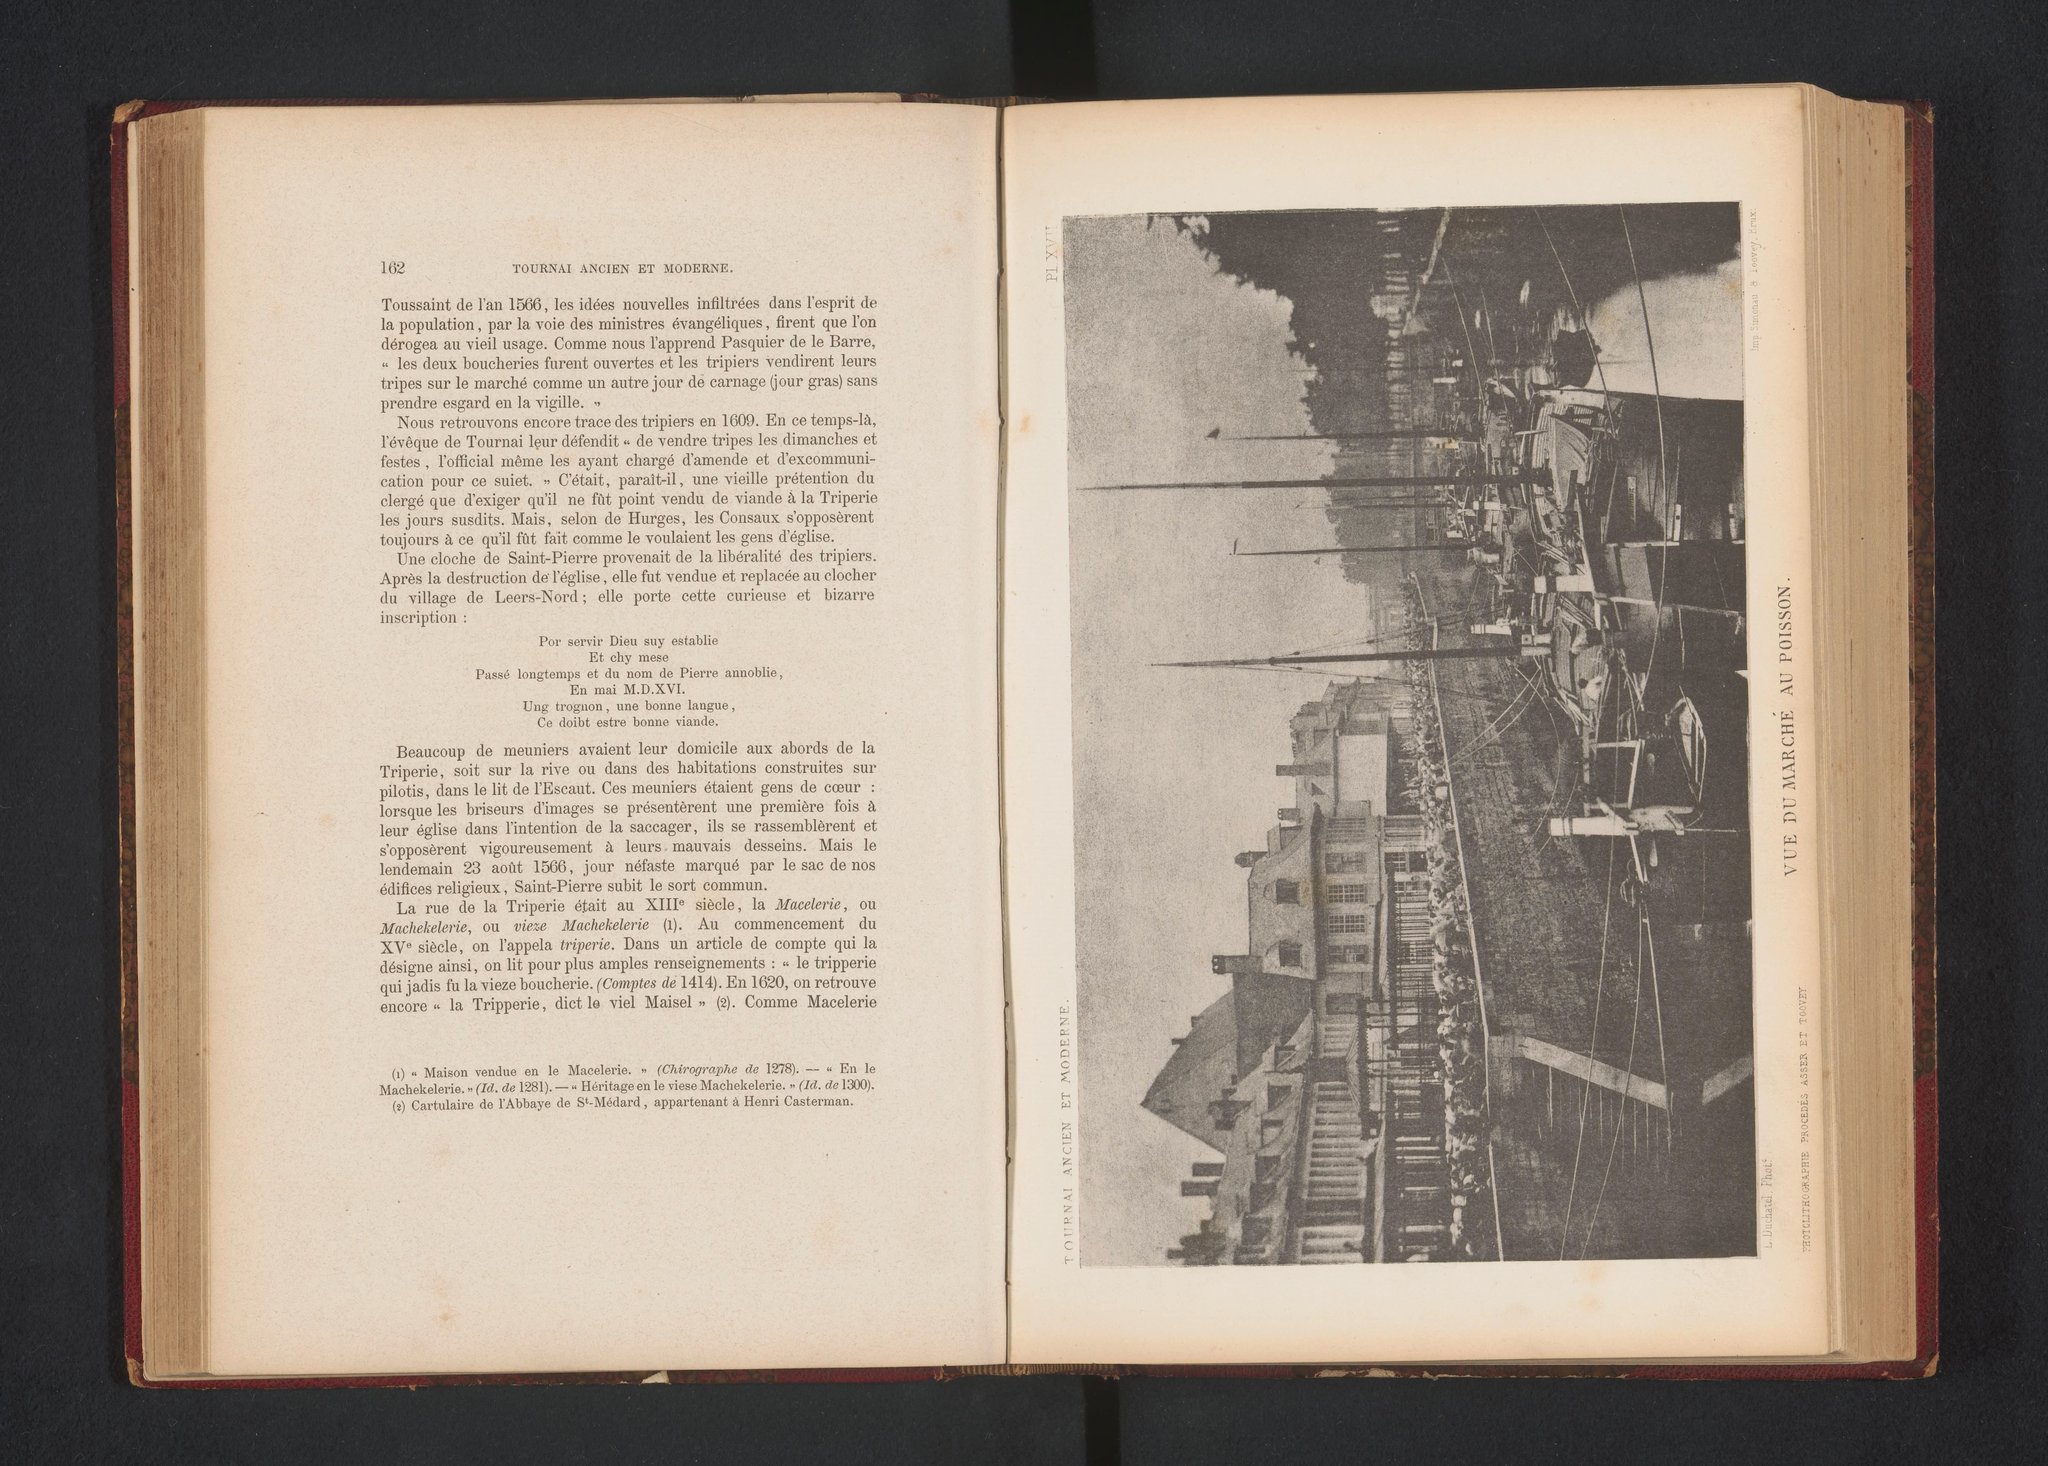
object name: photomechanical print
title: Gezicht op de Vismarkt in Doornik, België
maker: l. duchatel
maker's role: fotograaf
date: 1859-1864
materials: paper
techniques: photolithography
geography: antwerp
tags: harbour, market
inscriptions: number: ‘Pl. XVII’, inscription: ‘PHOTOLITHOGRAPHIE PROCEDÉS ASSER ET TOOVEY’